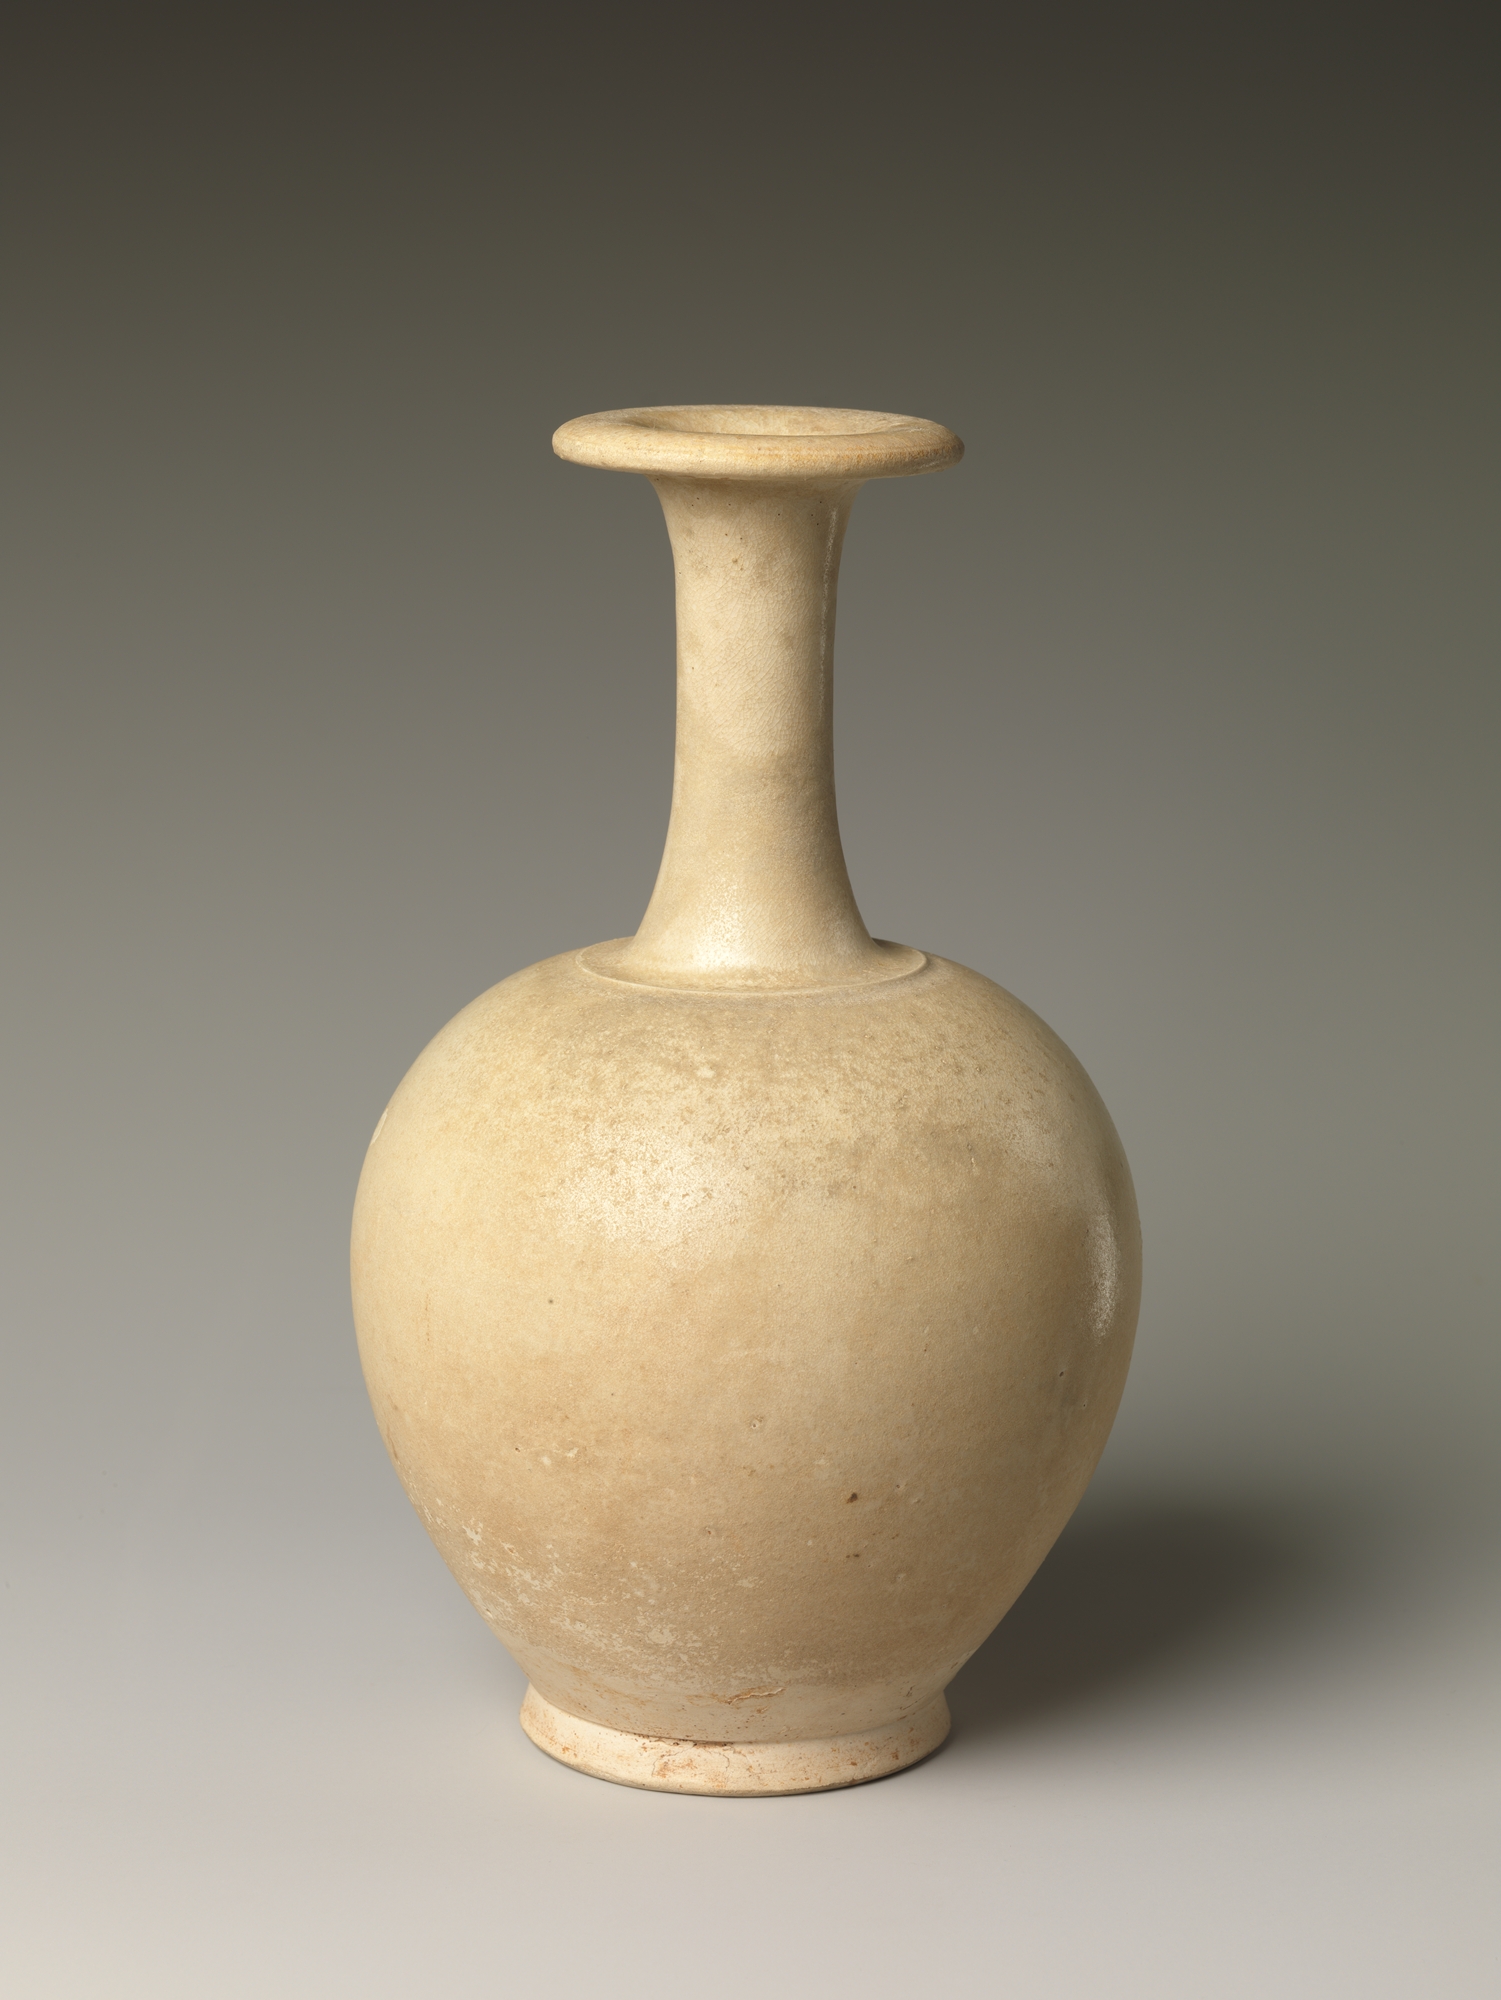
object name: bottle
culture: chinese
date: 567-700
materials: glaze, stoneware